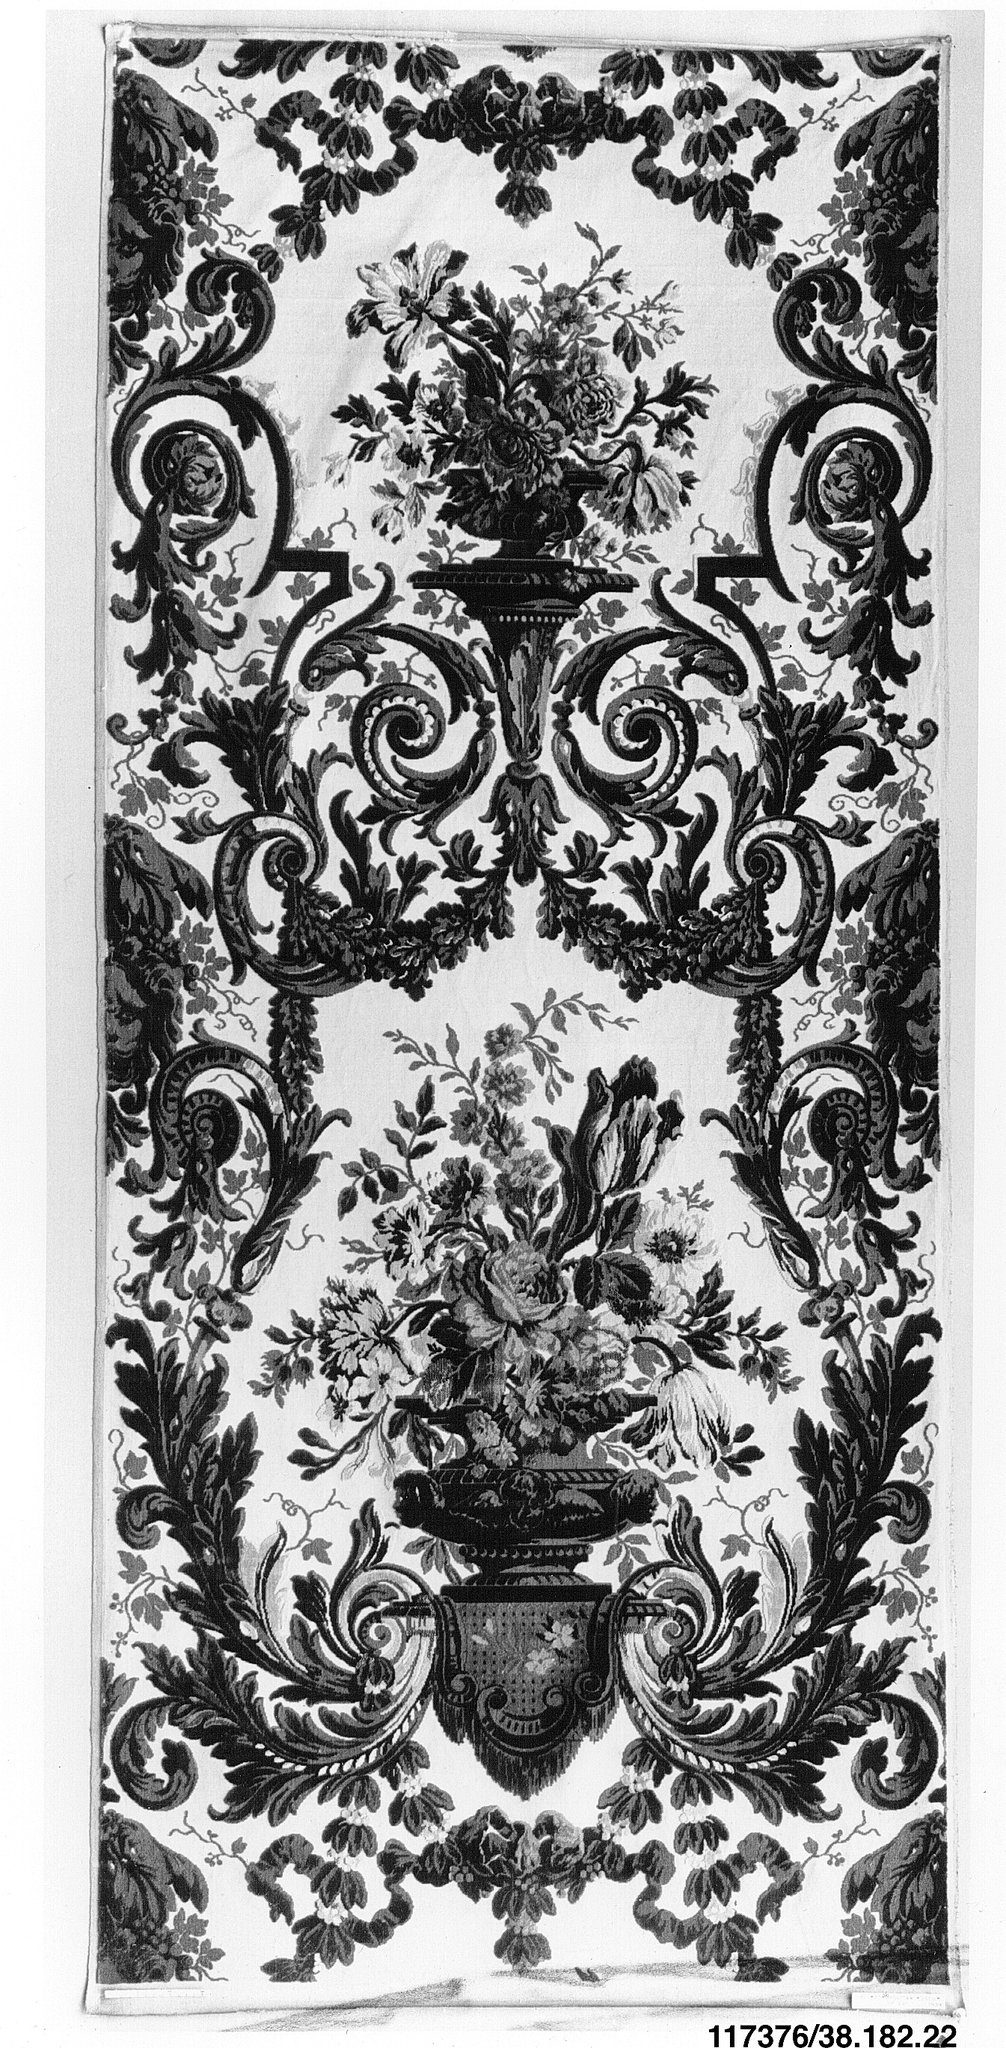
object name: piece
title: Length of velvet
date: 1840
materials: silk, velvet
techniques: cutting, voiding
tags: flowers